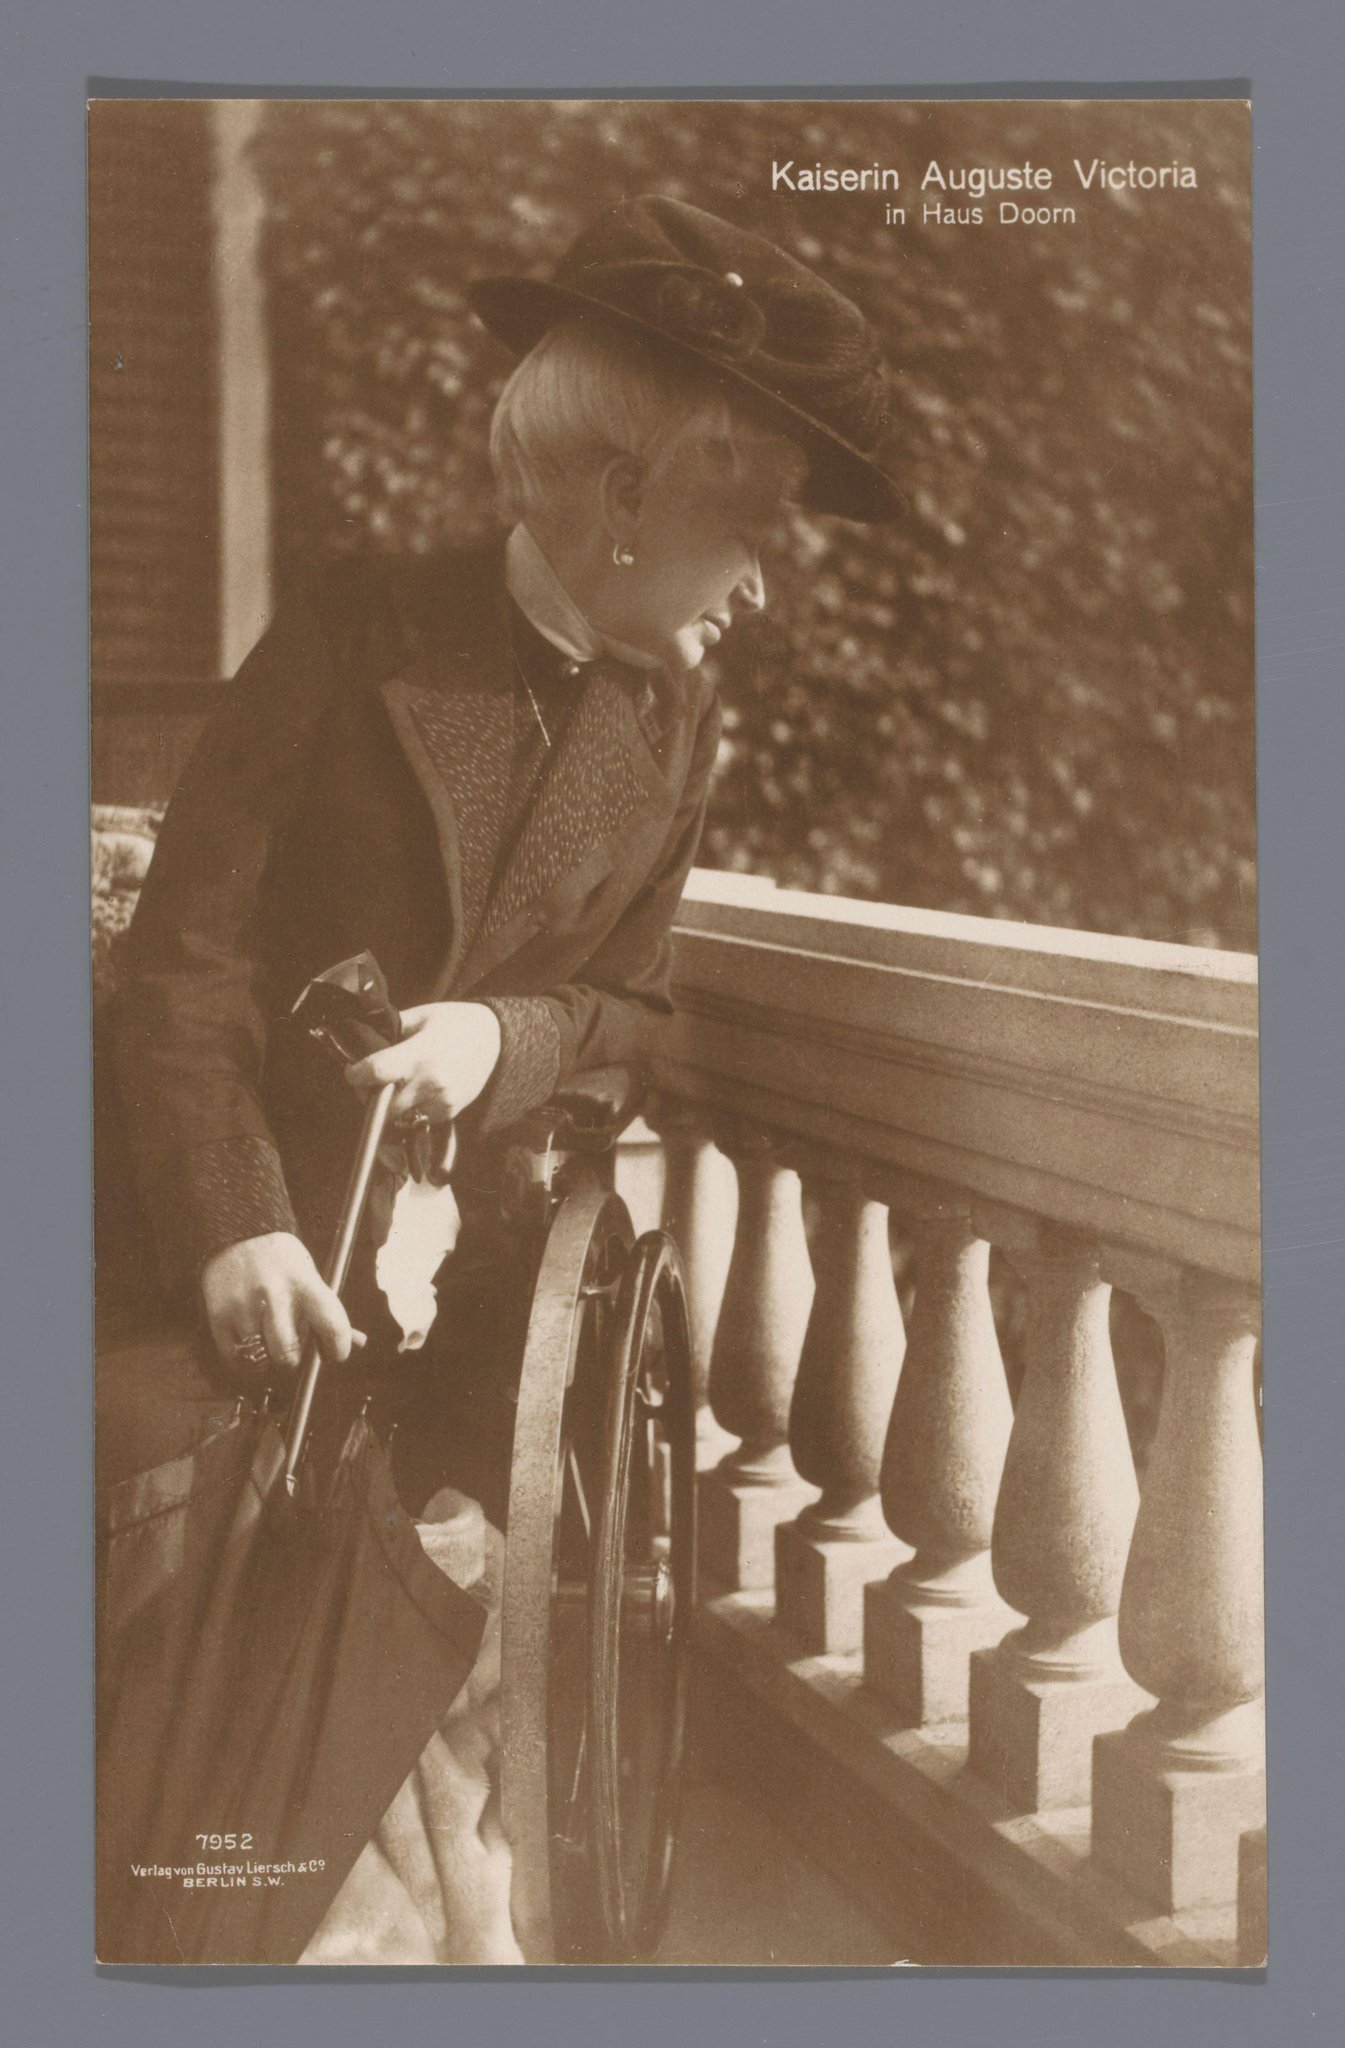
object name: photograph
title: Kaiserin Auguste Victoria in Haus Doorn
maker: Anonymous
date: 1920-1921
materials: paper, cardboard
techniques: gelatin silver print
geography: berlin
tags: augusta victoria (keizerin van duitsland), historical persons, old woman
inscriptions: inscription: ‘7952/ Verlag von Gustav Liersch & Co./ Berlin S.W.’